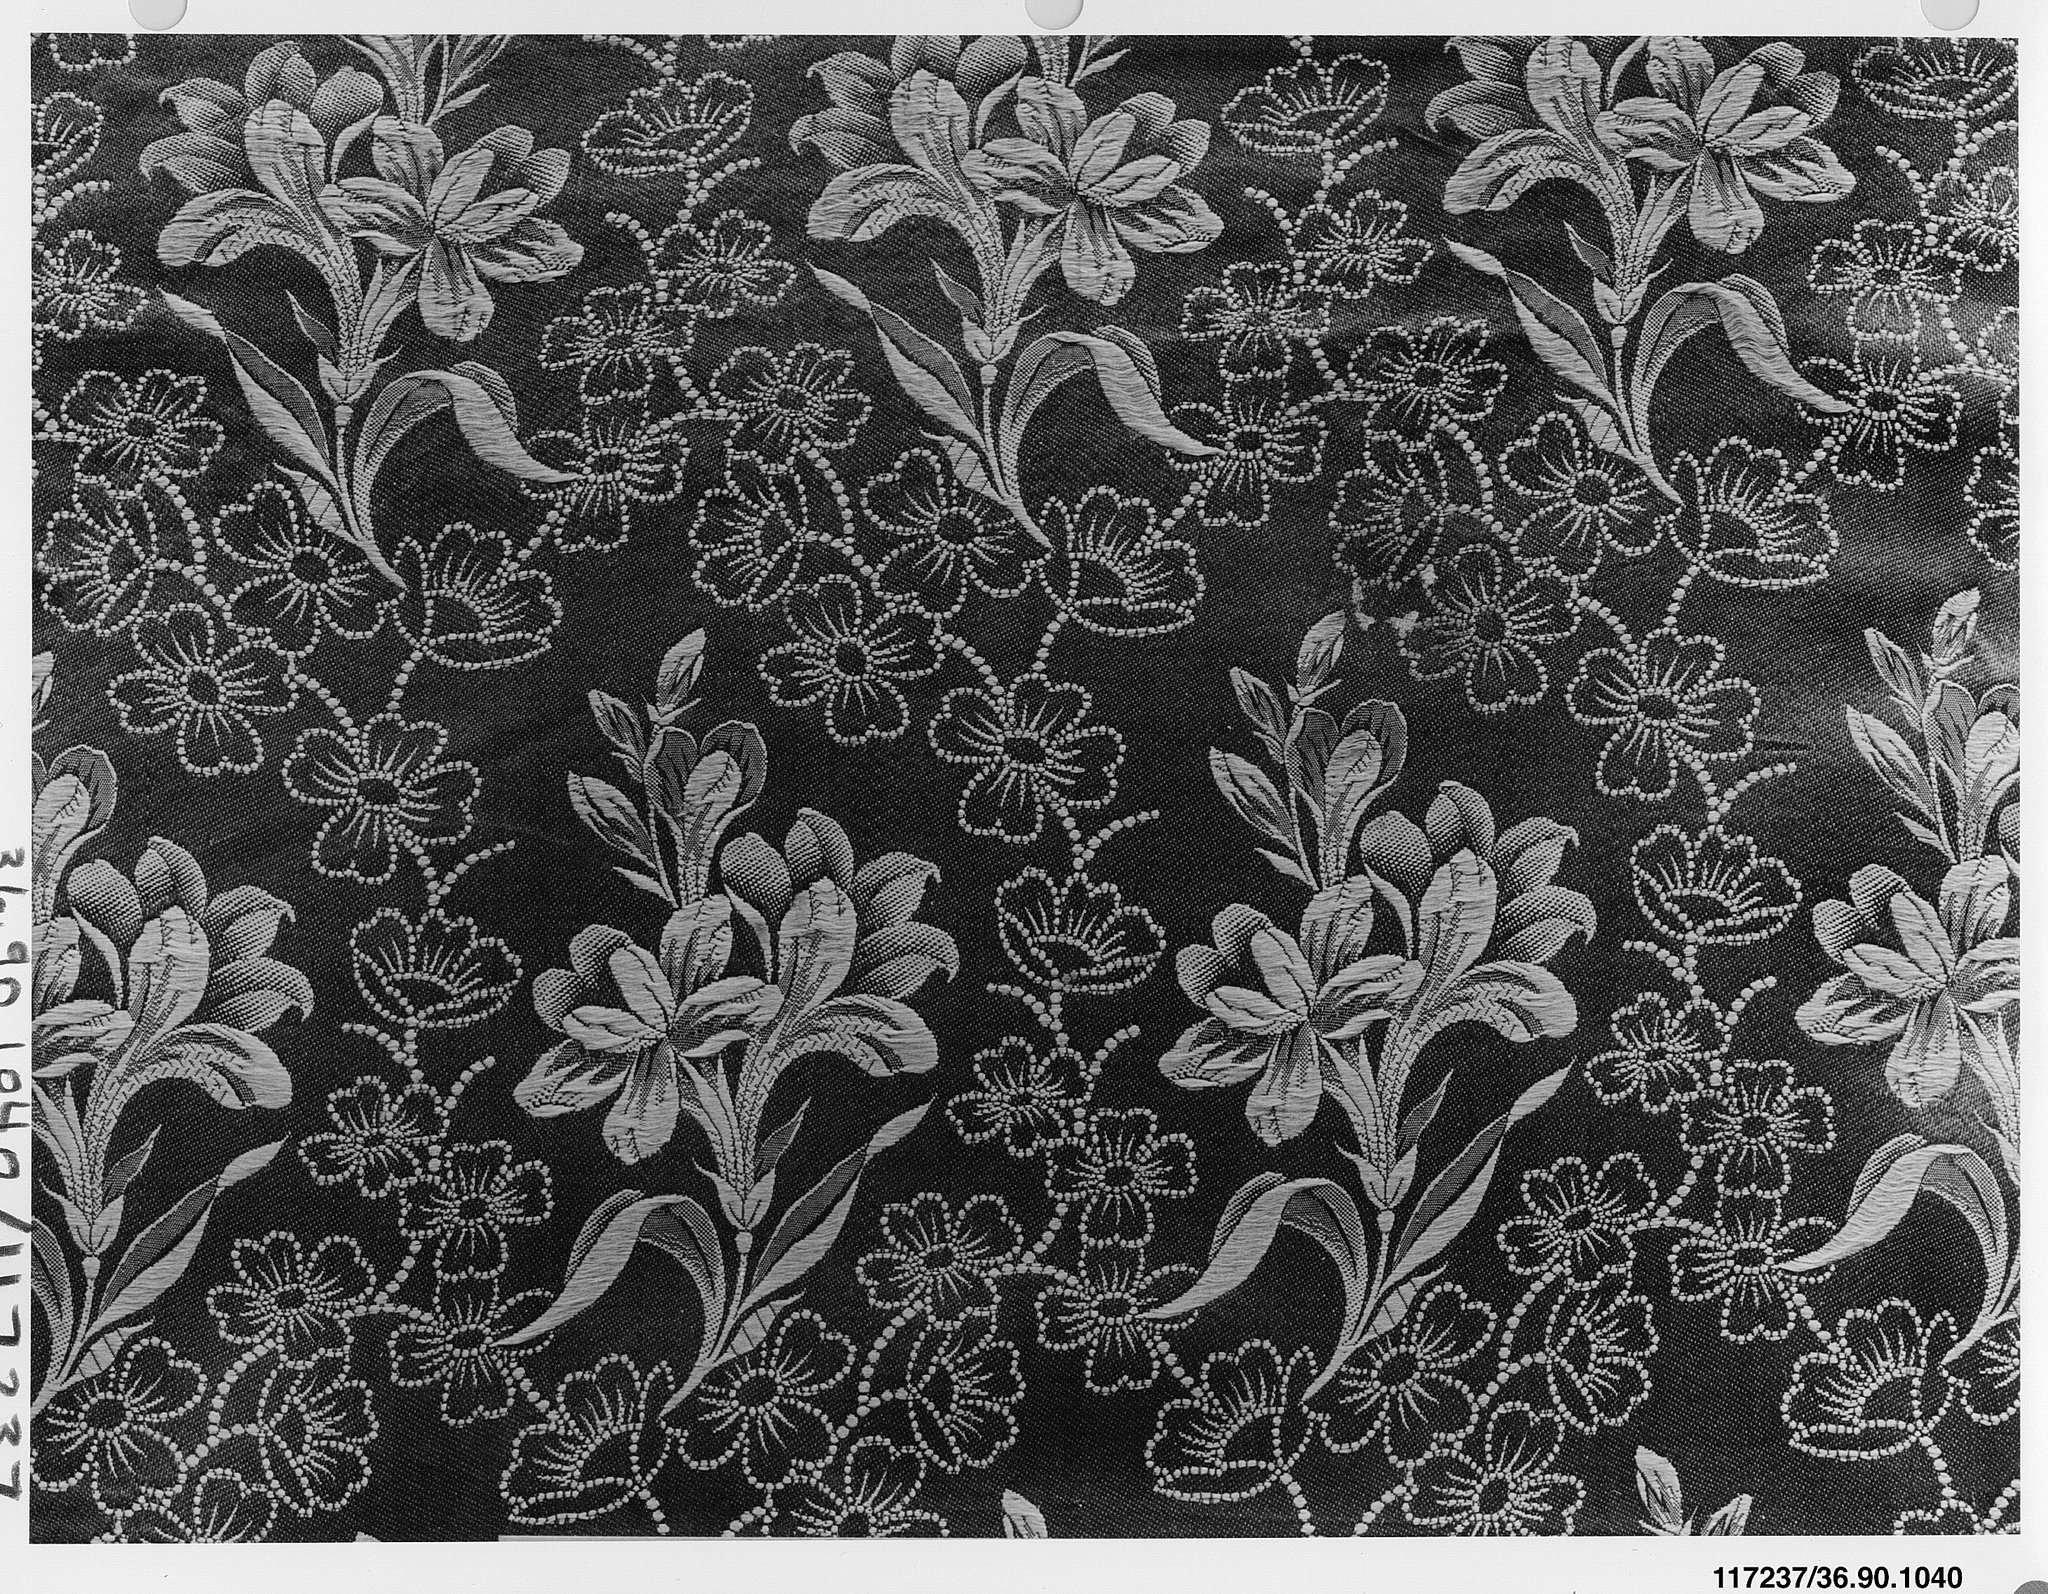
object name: piece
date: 1835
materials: silk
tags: flowers,leaves